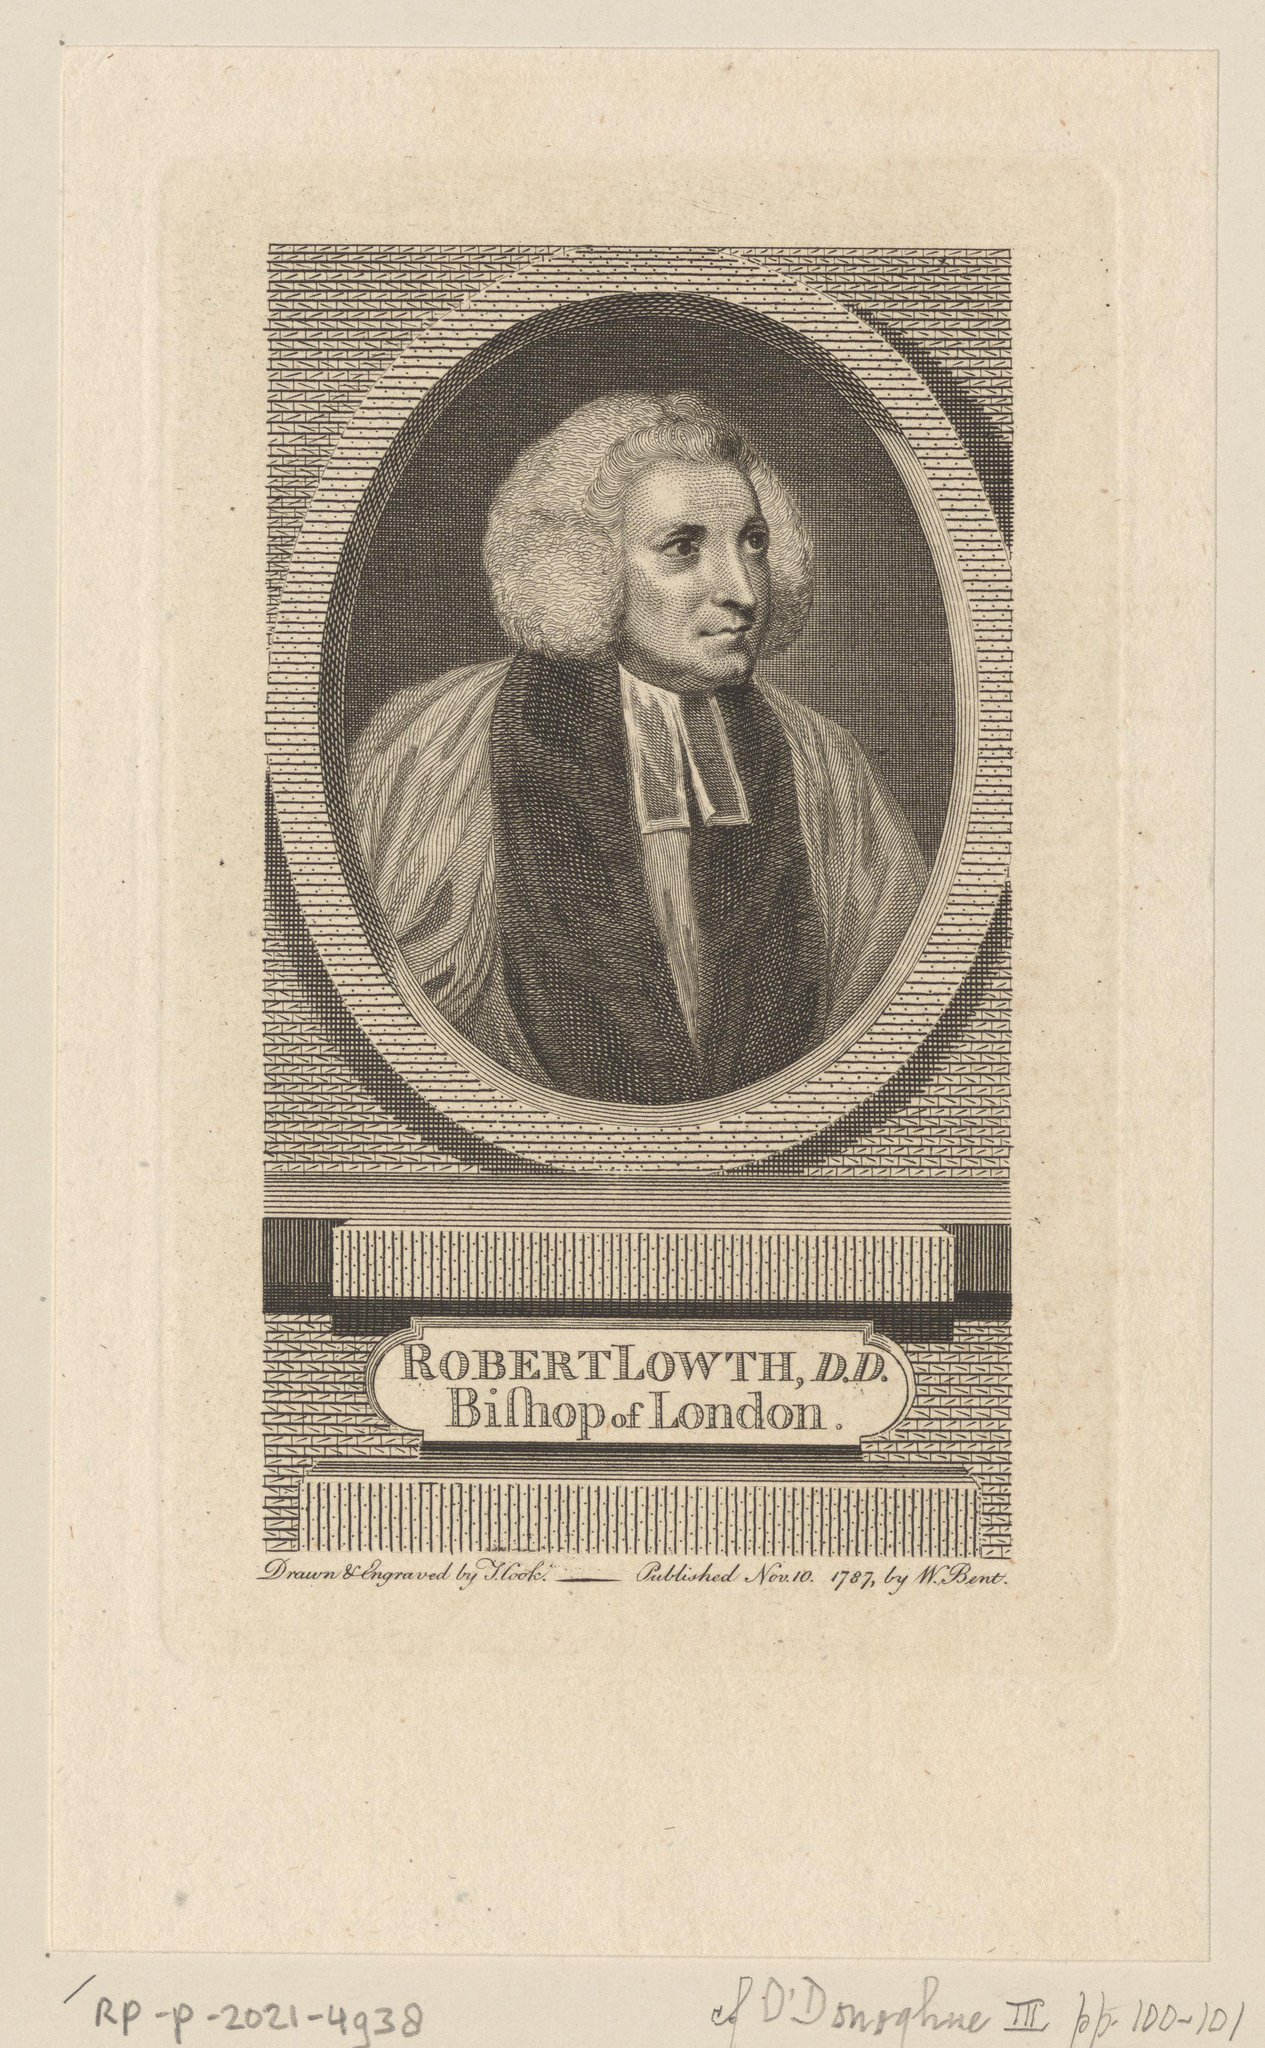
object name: print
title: Portret van Robert Lowth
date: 1778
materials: paper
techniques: engraving, etching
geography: england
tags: archbishop, bishop, etc. (roman catholic), historical persons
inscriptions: date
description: Prent waarschijnlijk uit: The Universal Magazine of Knowledge and Pleasure, november 1787.